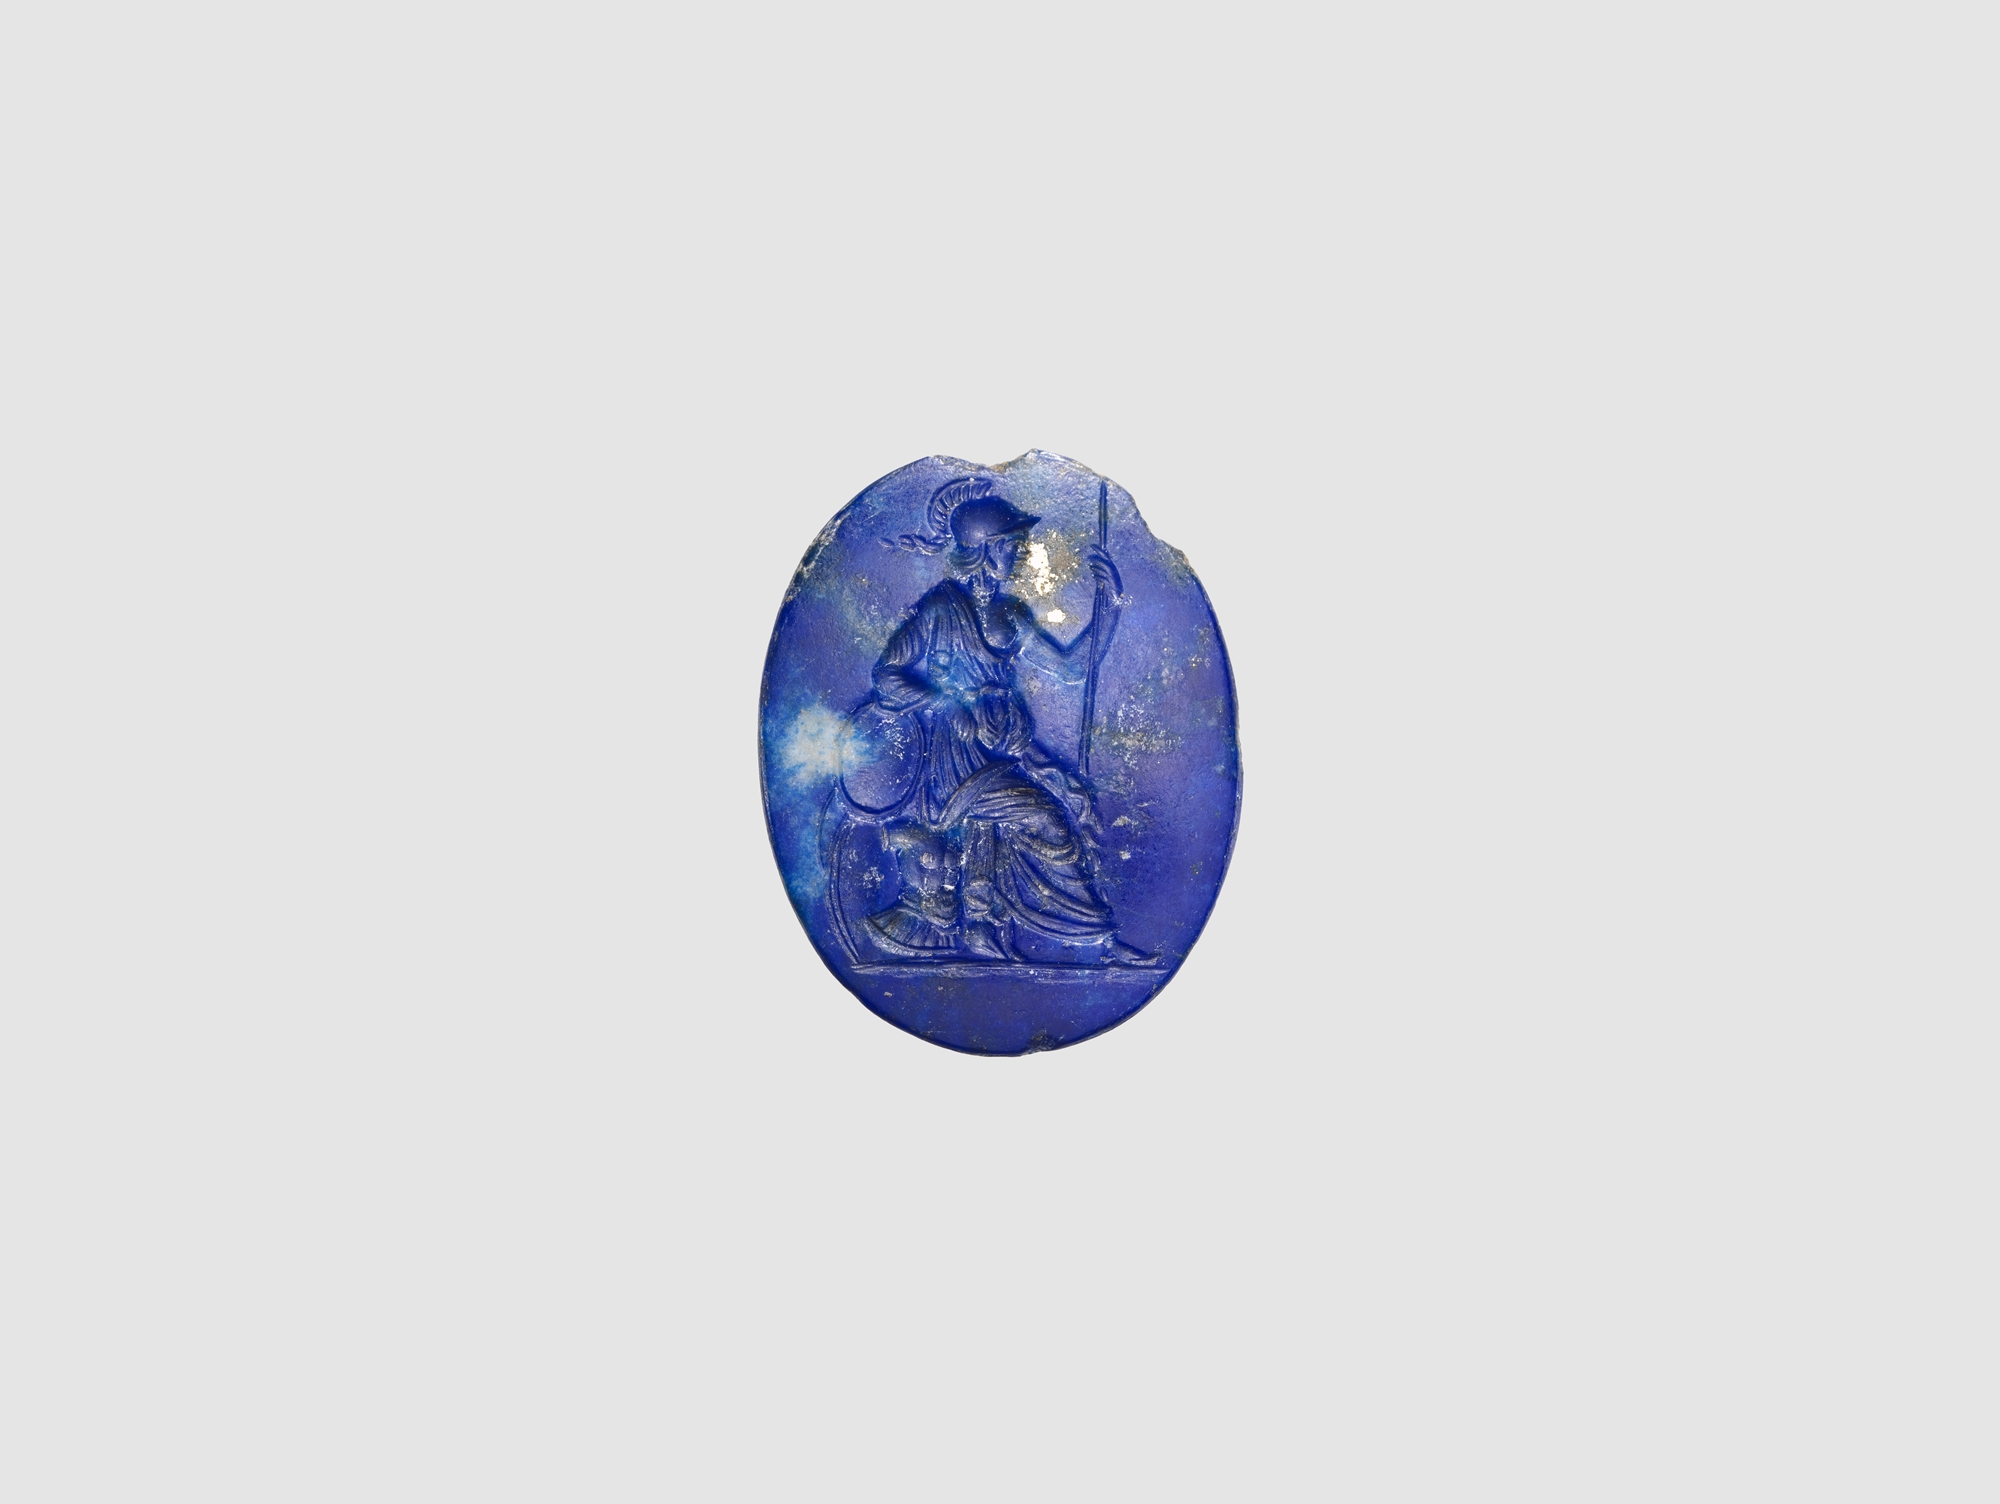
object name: intaglio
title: Lapis lazuli ring stone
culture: post-classical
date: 7000 BCE-330 CE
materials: lapis lazuli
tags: armor,athena